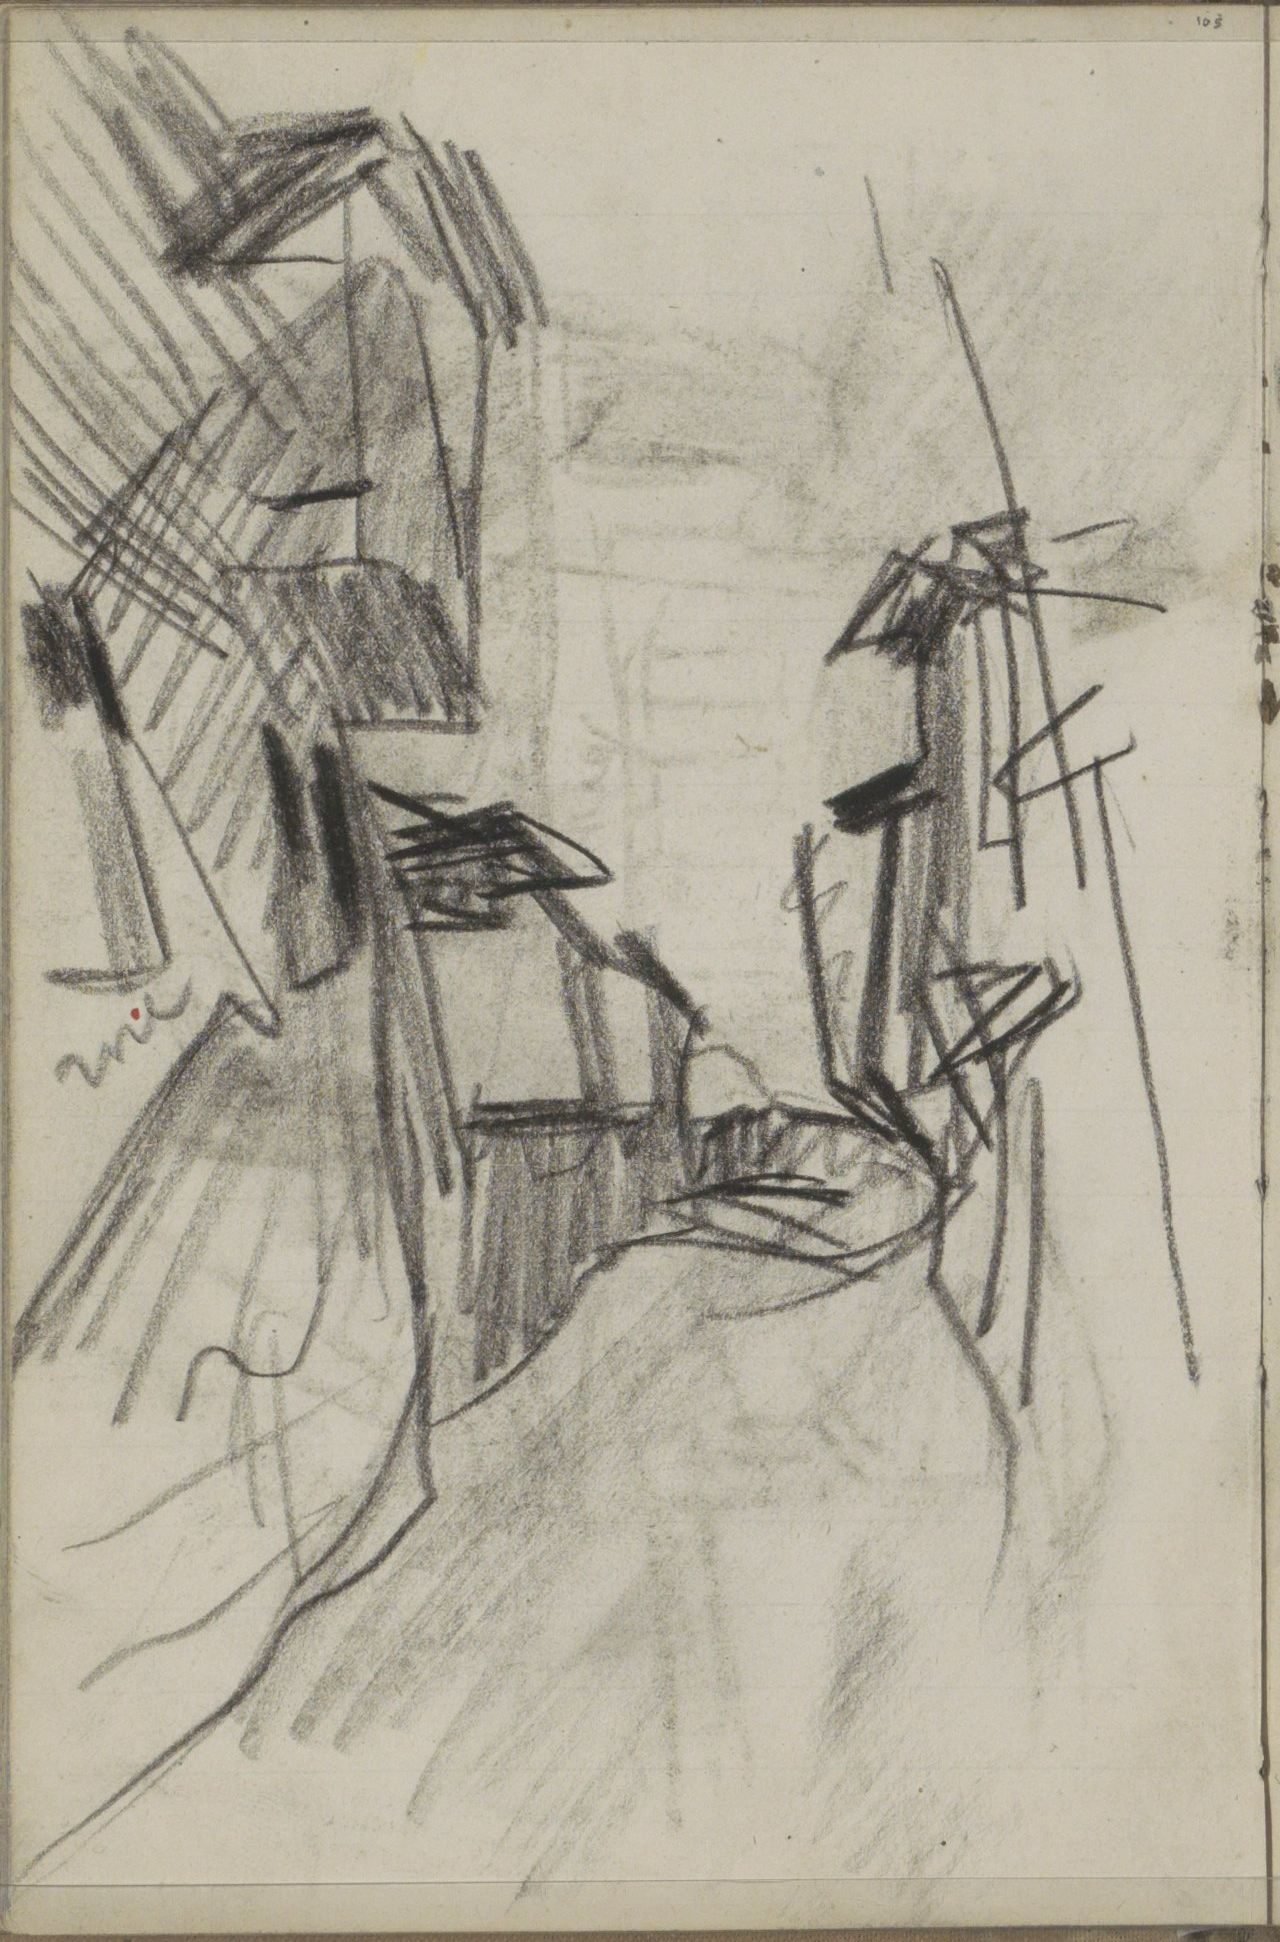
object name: sketchbook leaf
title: Straat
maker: marius bauer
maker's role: draughtsman, print maker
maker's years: 1867-1932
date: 1888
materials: chalk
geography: istanbul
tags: street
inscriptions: kleurnotitie, handgeschreven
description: Pagina 105 uit een schetsboek met 56 bladen.